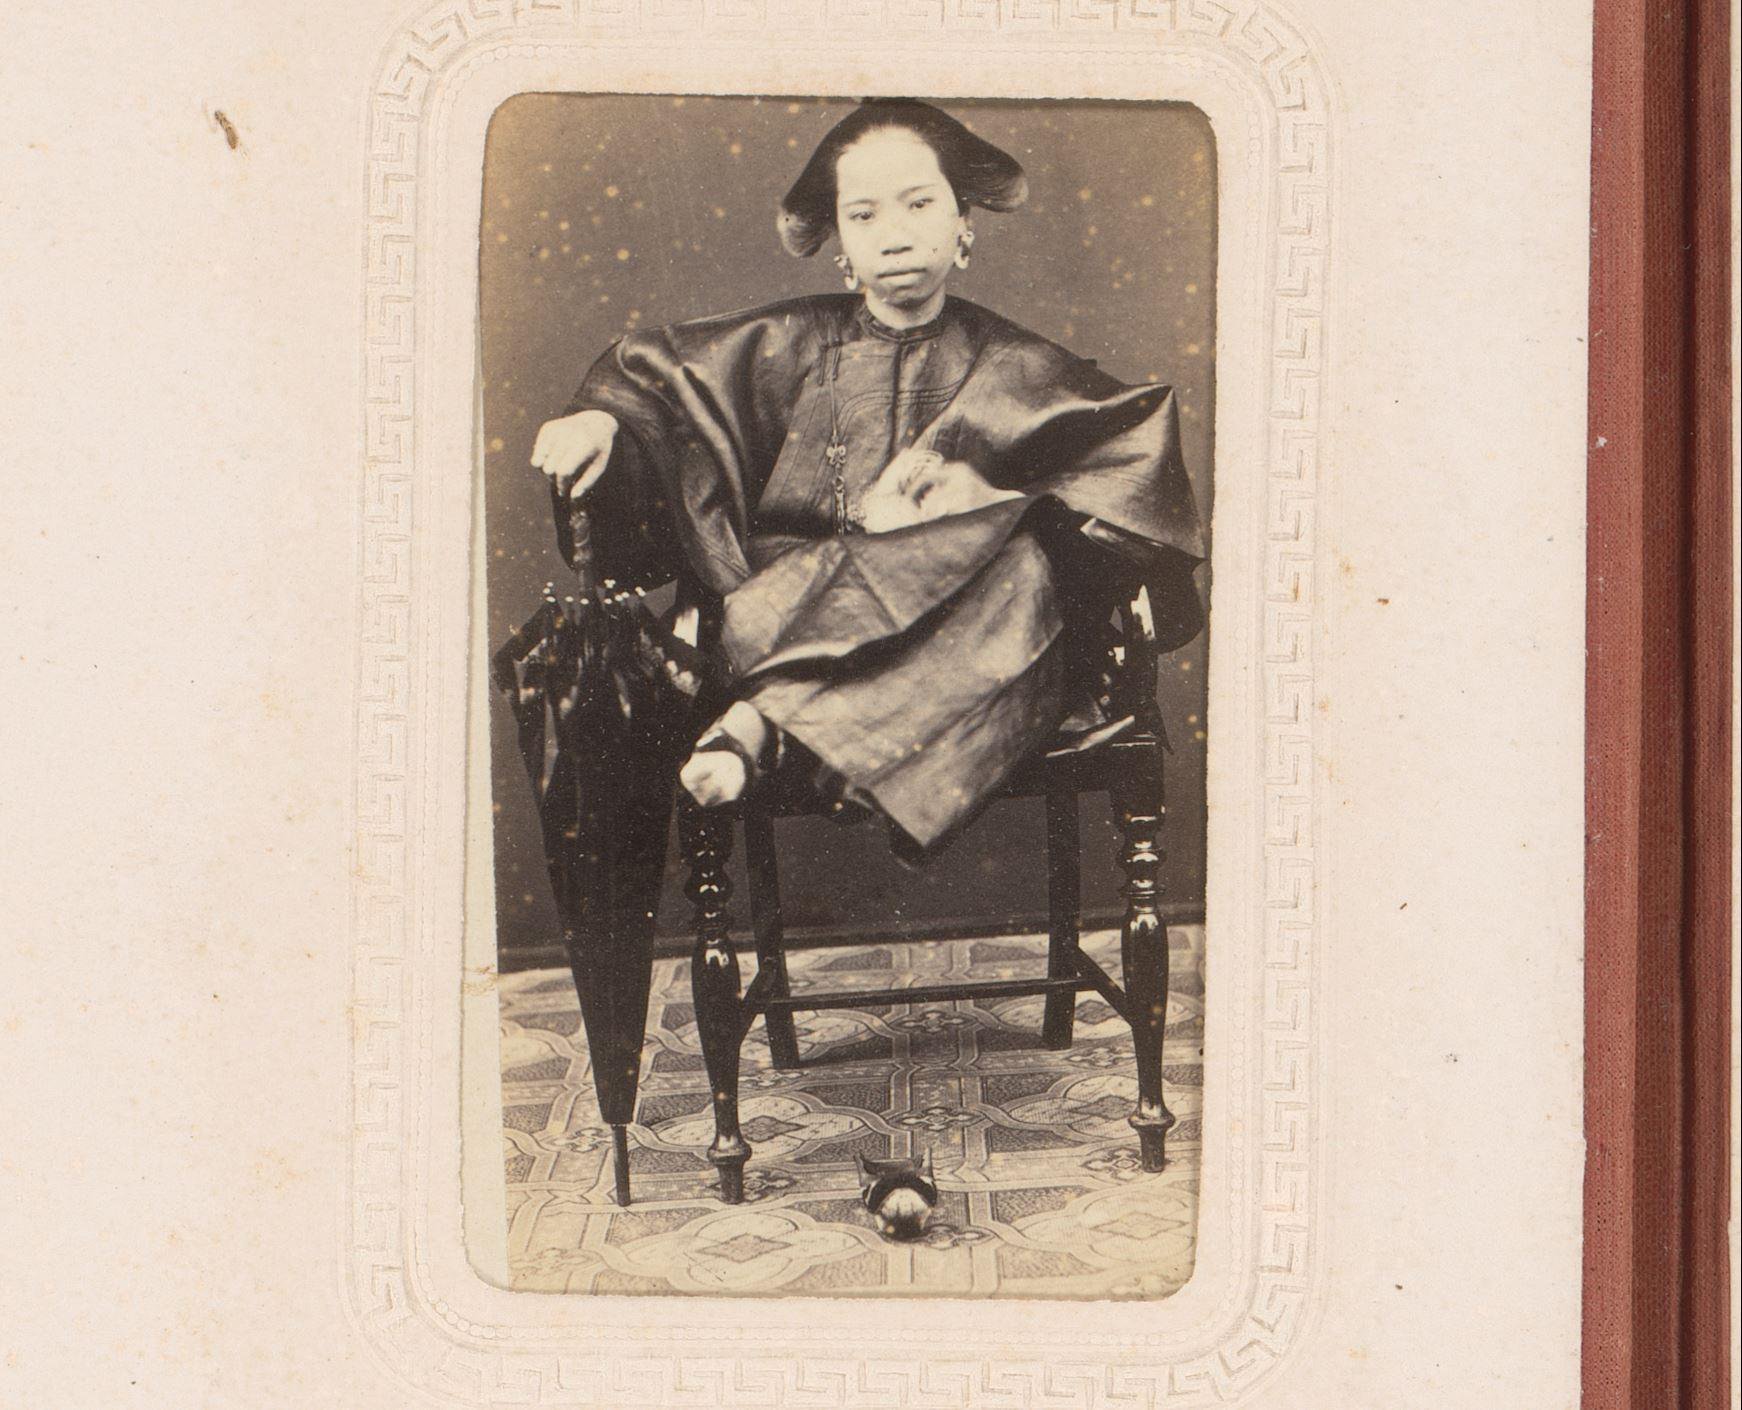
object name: carte de visite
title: Portret van een Chinese vrouw uit Macao met paraplu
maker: Anonymous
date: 1850-1880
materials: cardboard, photographic support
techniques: albumen print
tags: historical persons - bb - woman, umbrella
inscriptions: number: ‘6’